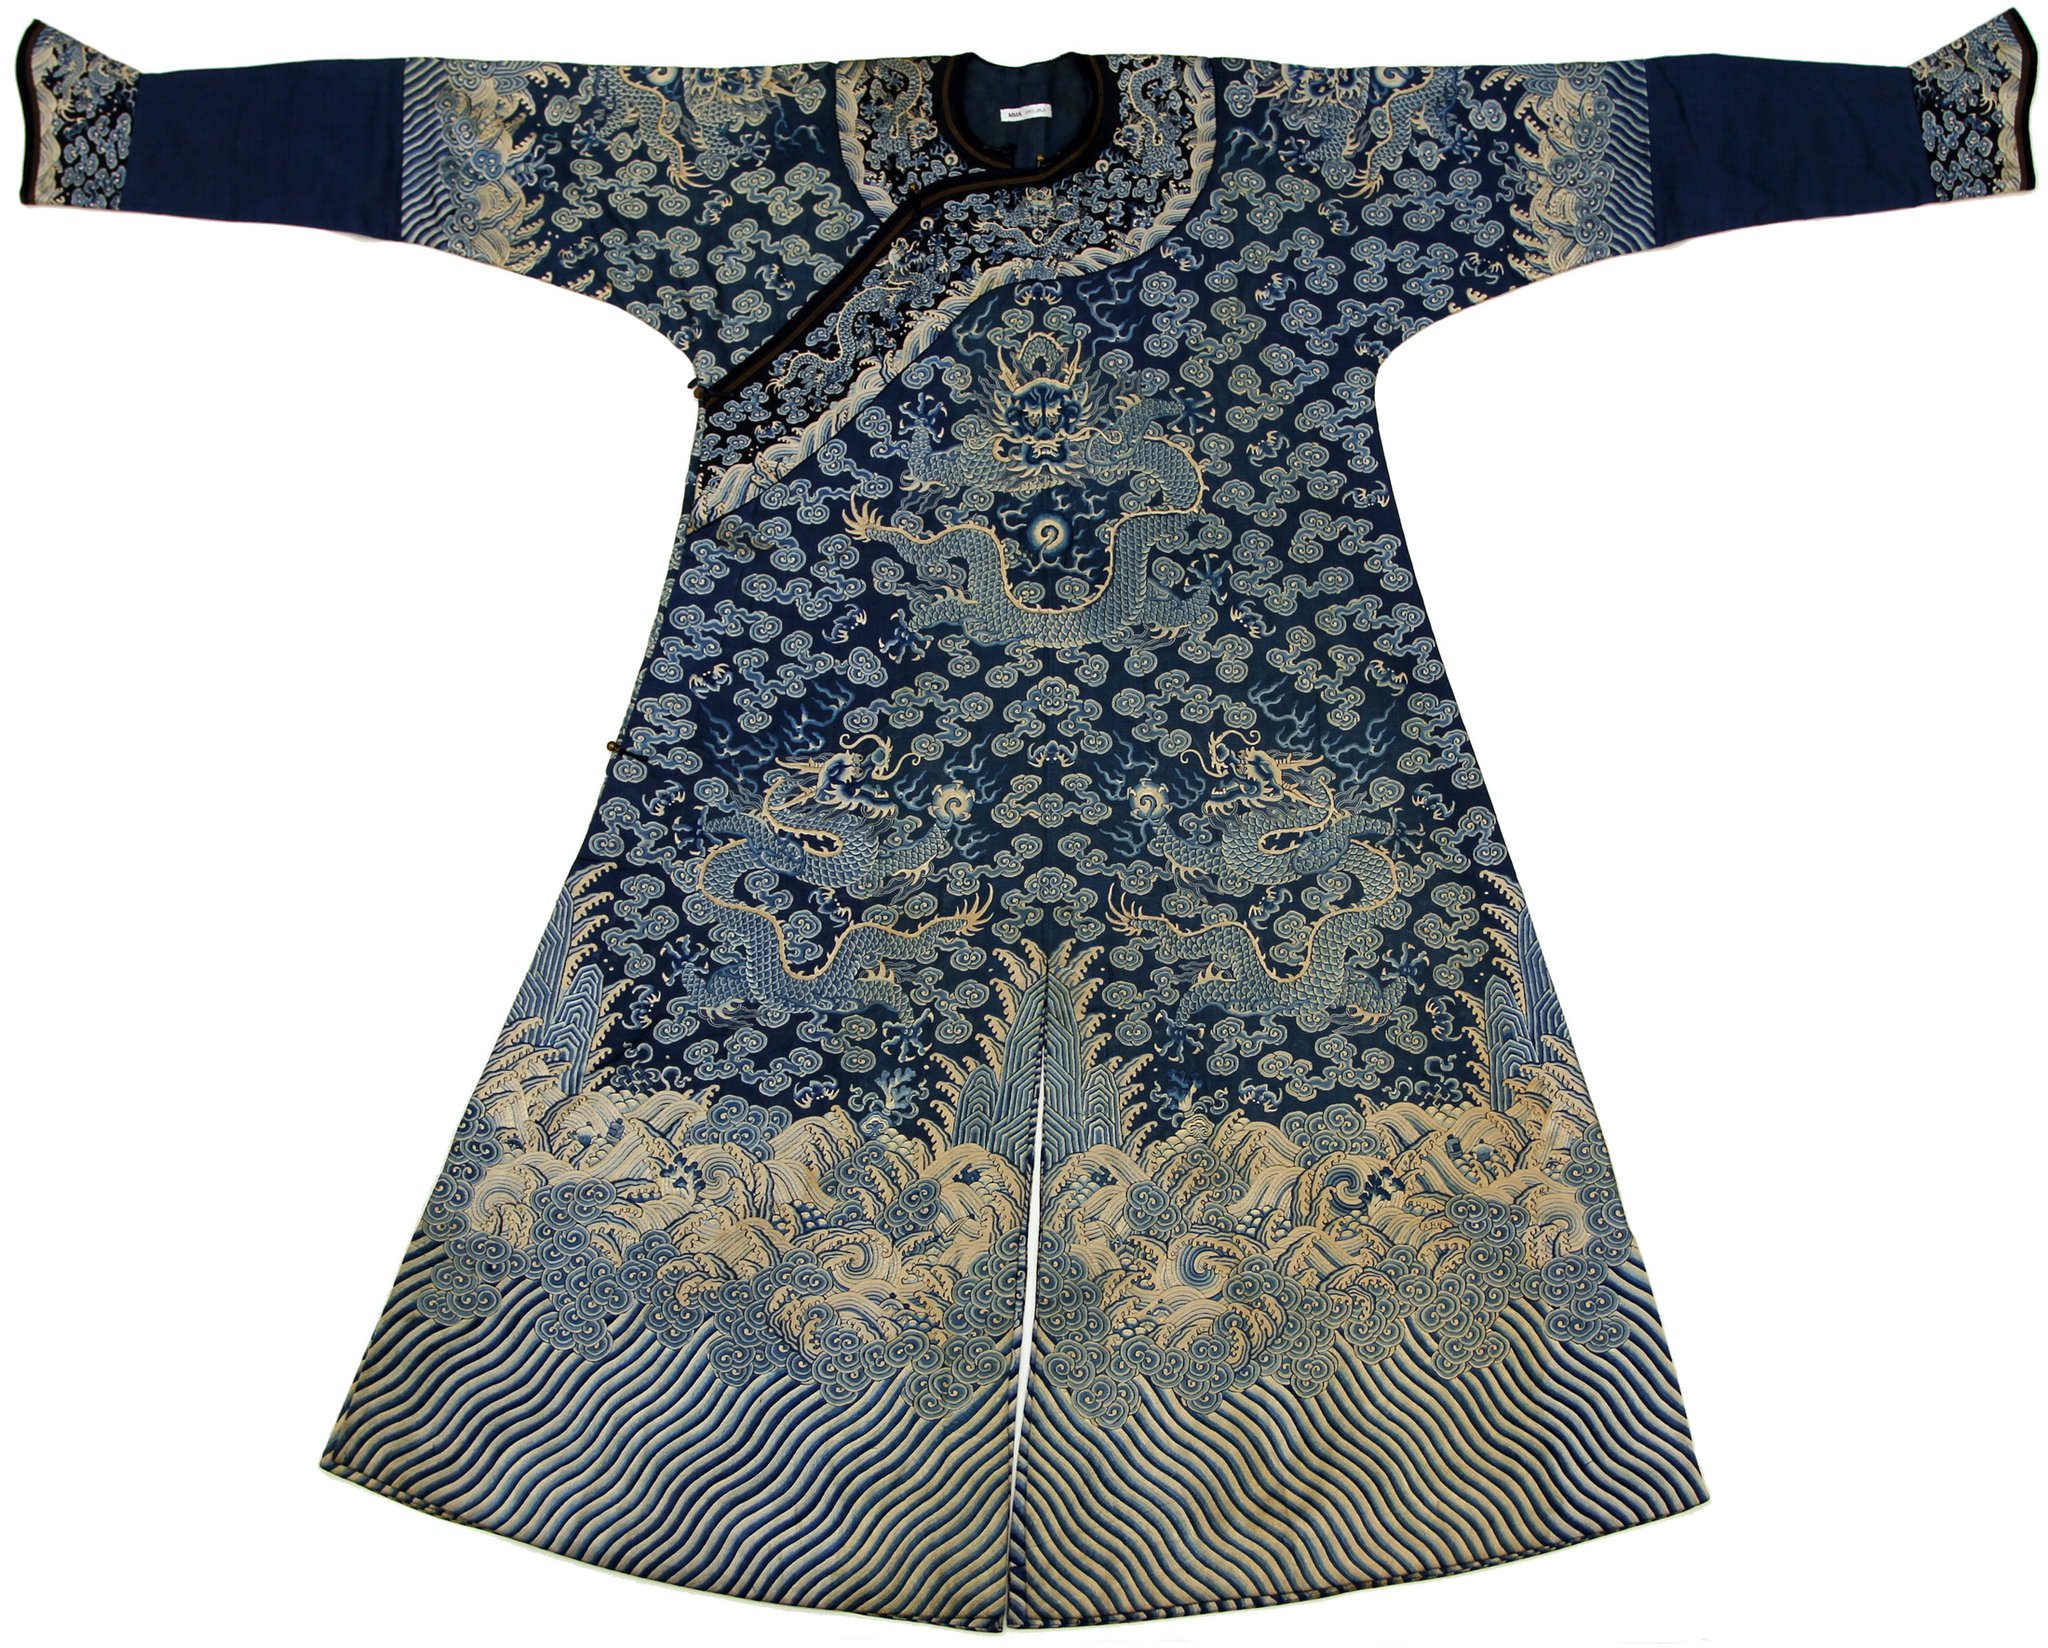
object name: five clawed dragon robe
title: Five-Clawed Dragon Robe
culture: chinese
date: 1701-1800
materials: silk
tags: dragons